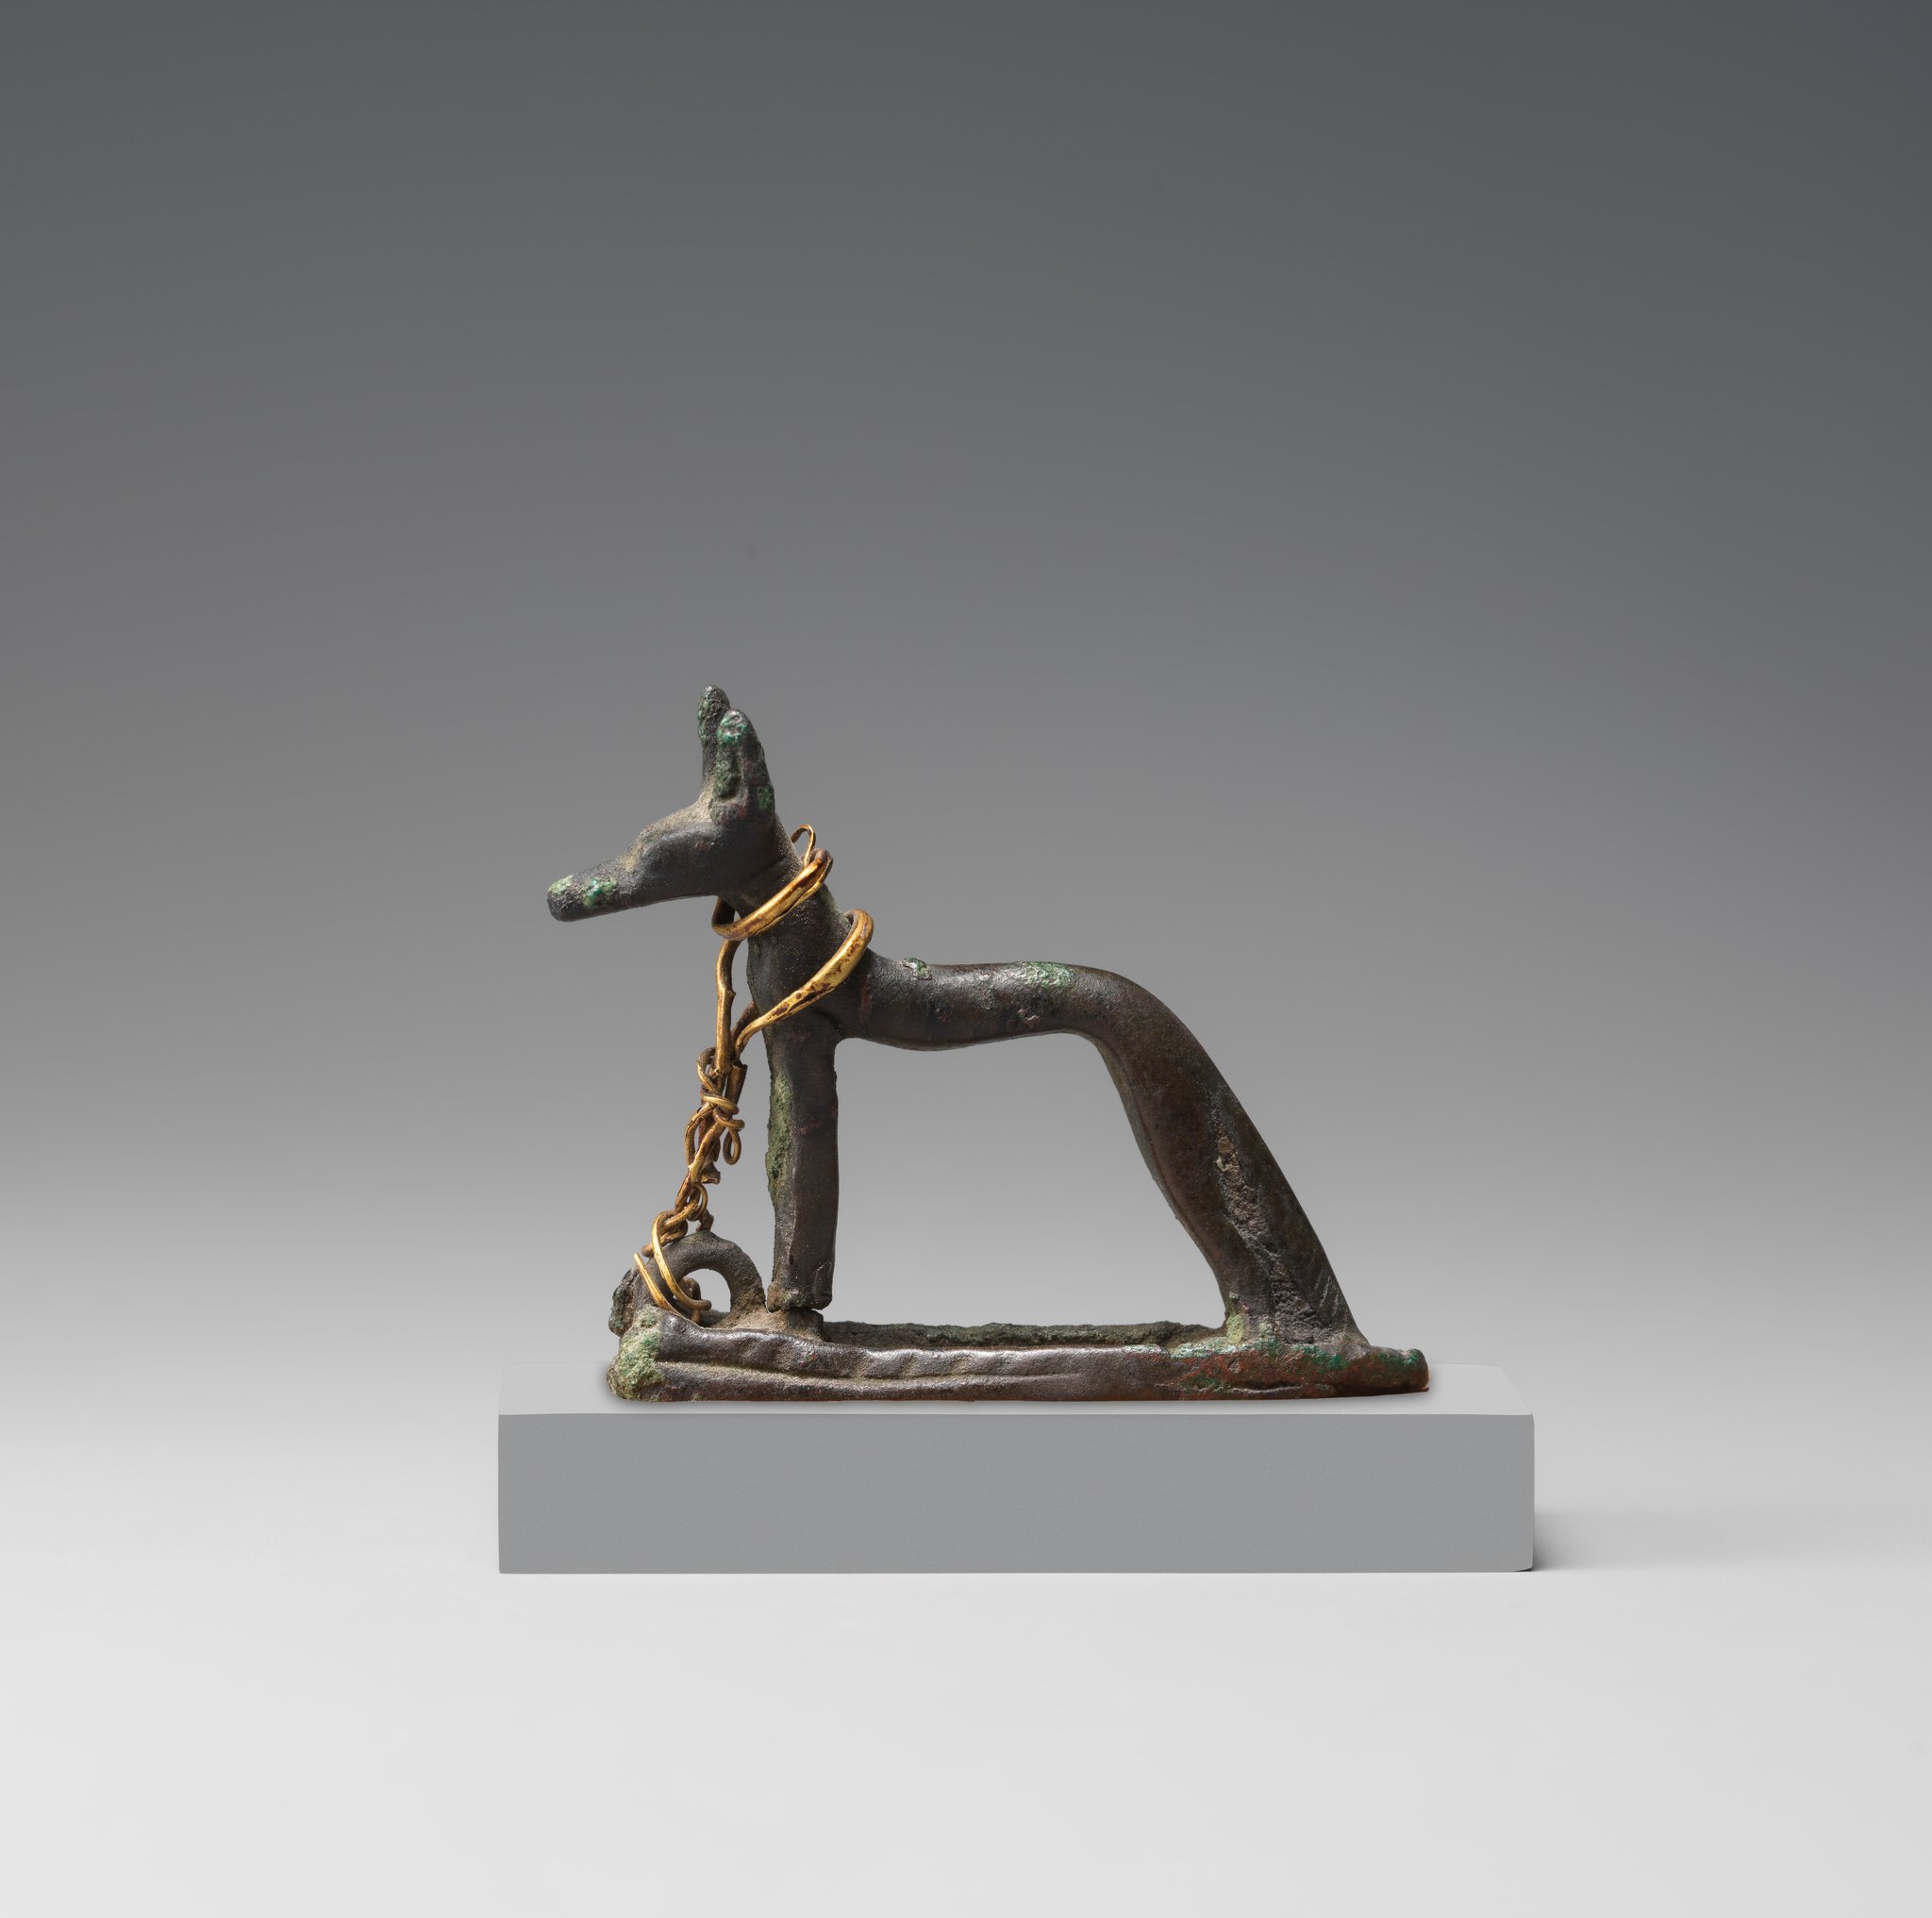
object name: wepwawet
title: Figurine of Wepwawet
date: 664-332 BCE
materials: metal, gold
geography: egypt